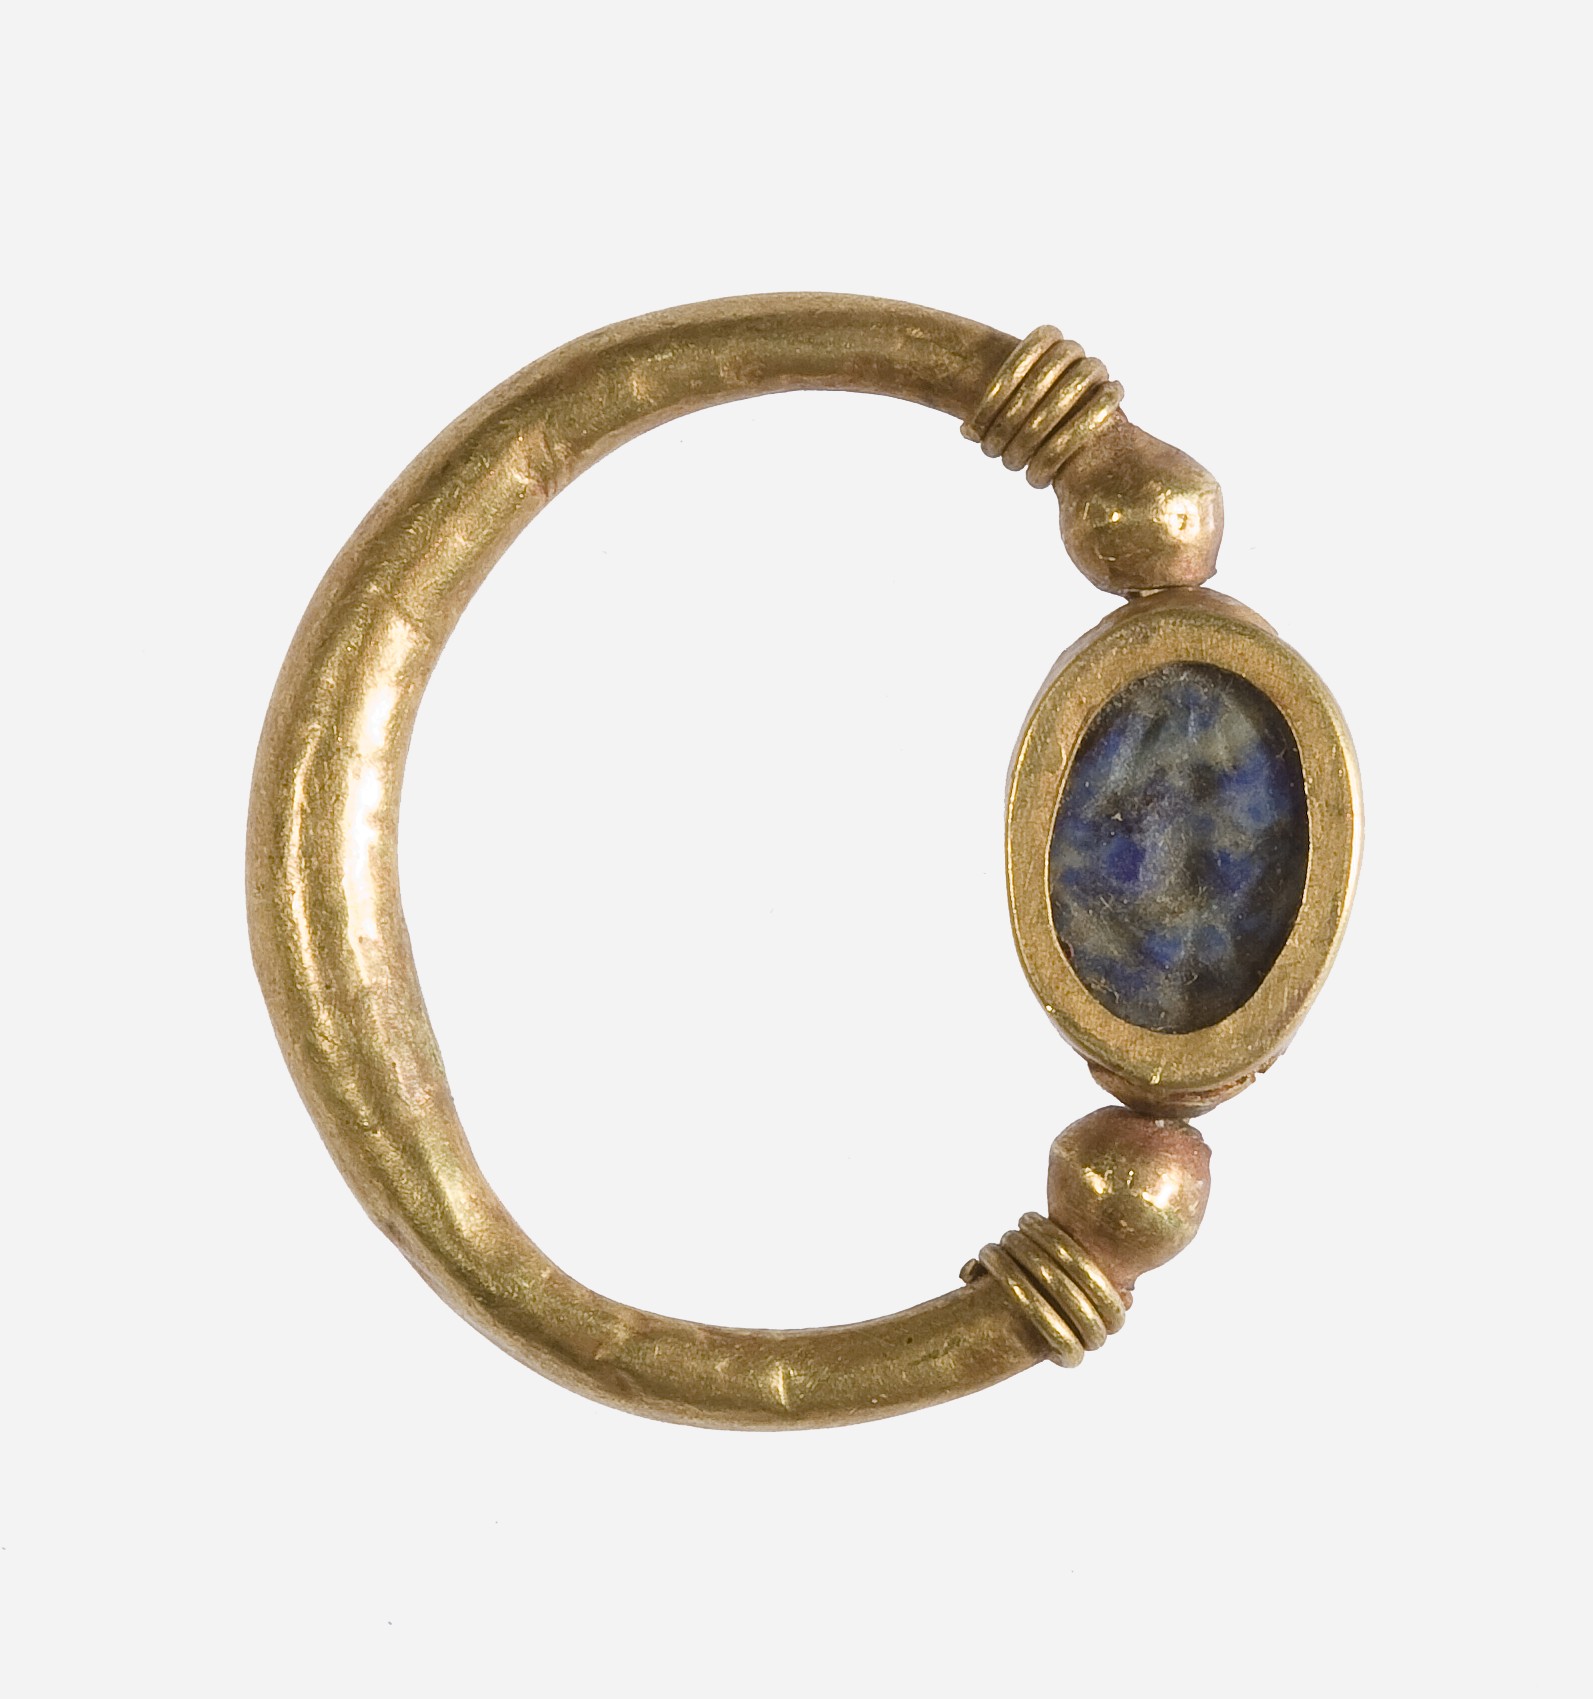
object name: ring with scarab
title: Scarab Finger Ring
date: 1295-1070 BCE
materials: gold, lapis lazuli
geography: egypt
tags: scarabs